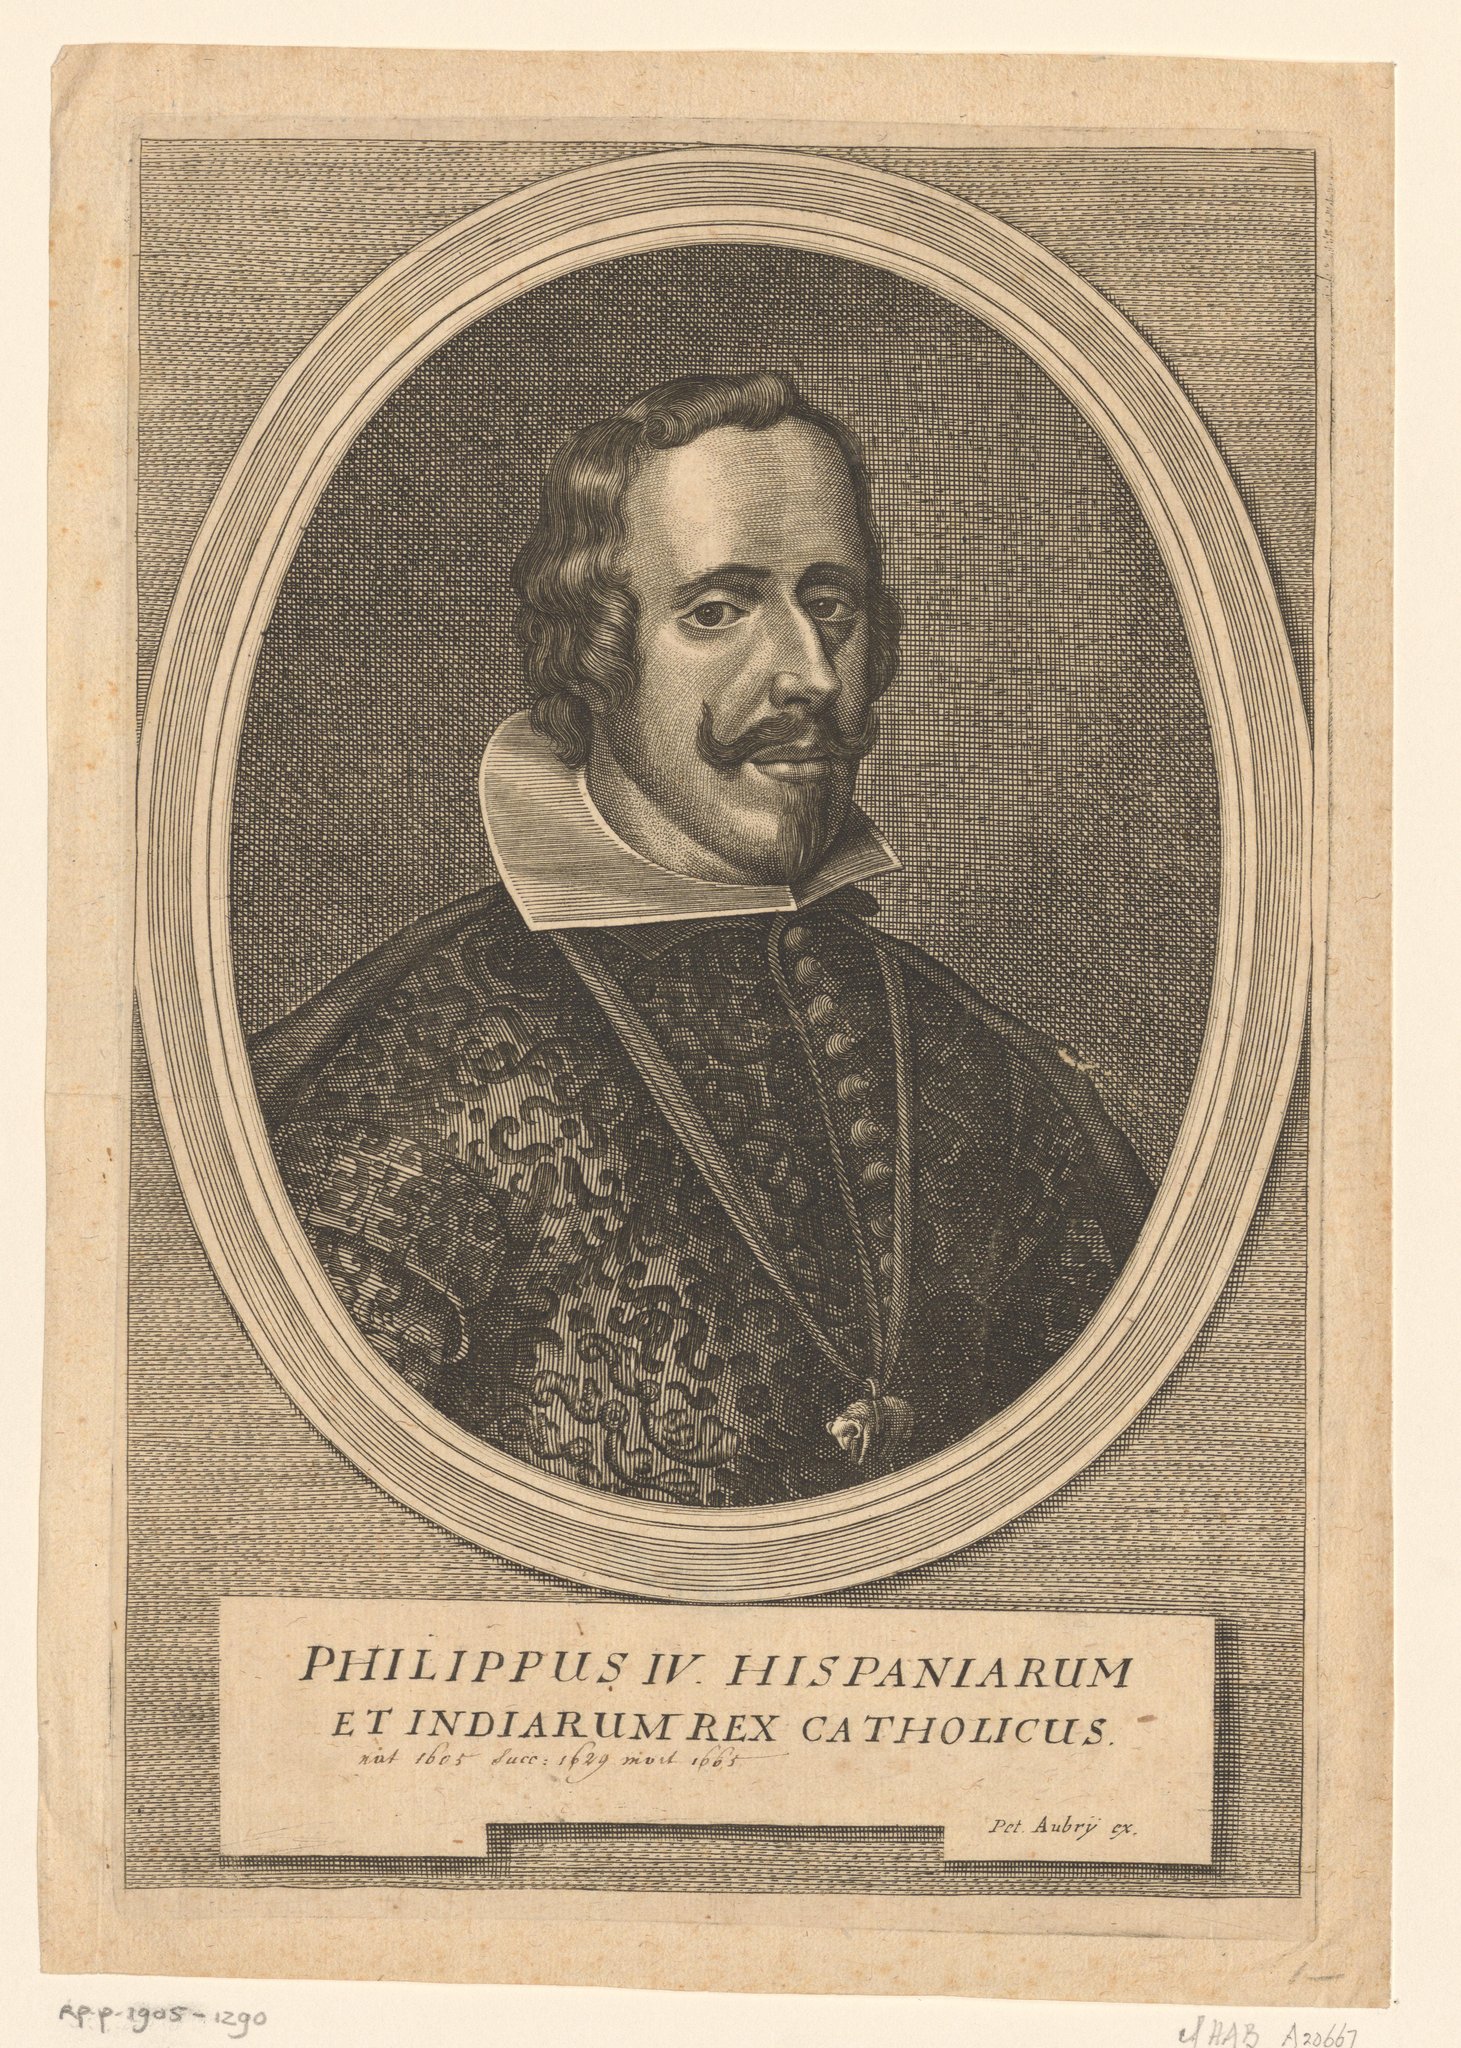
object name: print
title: Portret van Filips IV, koning van Spanje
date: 1630-1686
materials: paper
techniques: engraving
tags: filips iv (koning van spanje), adult man, historical persons, knighthood order of the golden fleece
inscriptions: collector's mark: Lugt 2228